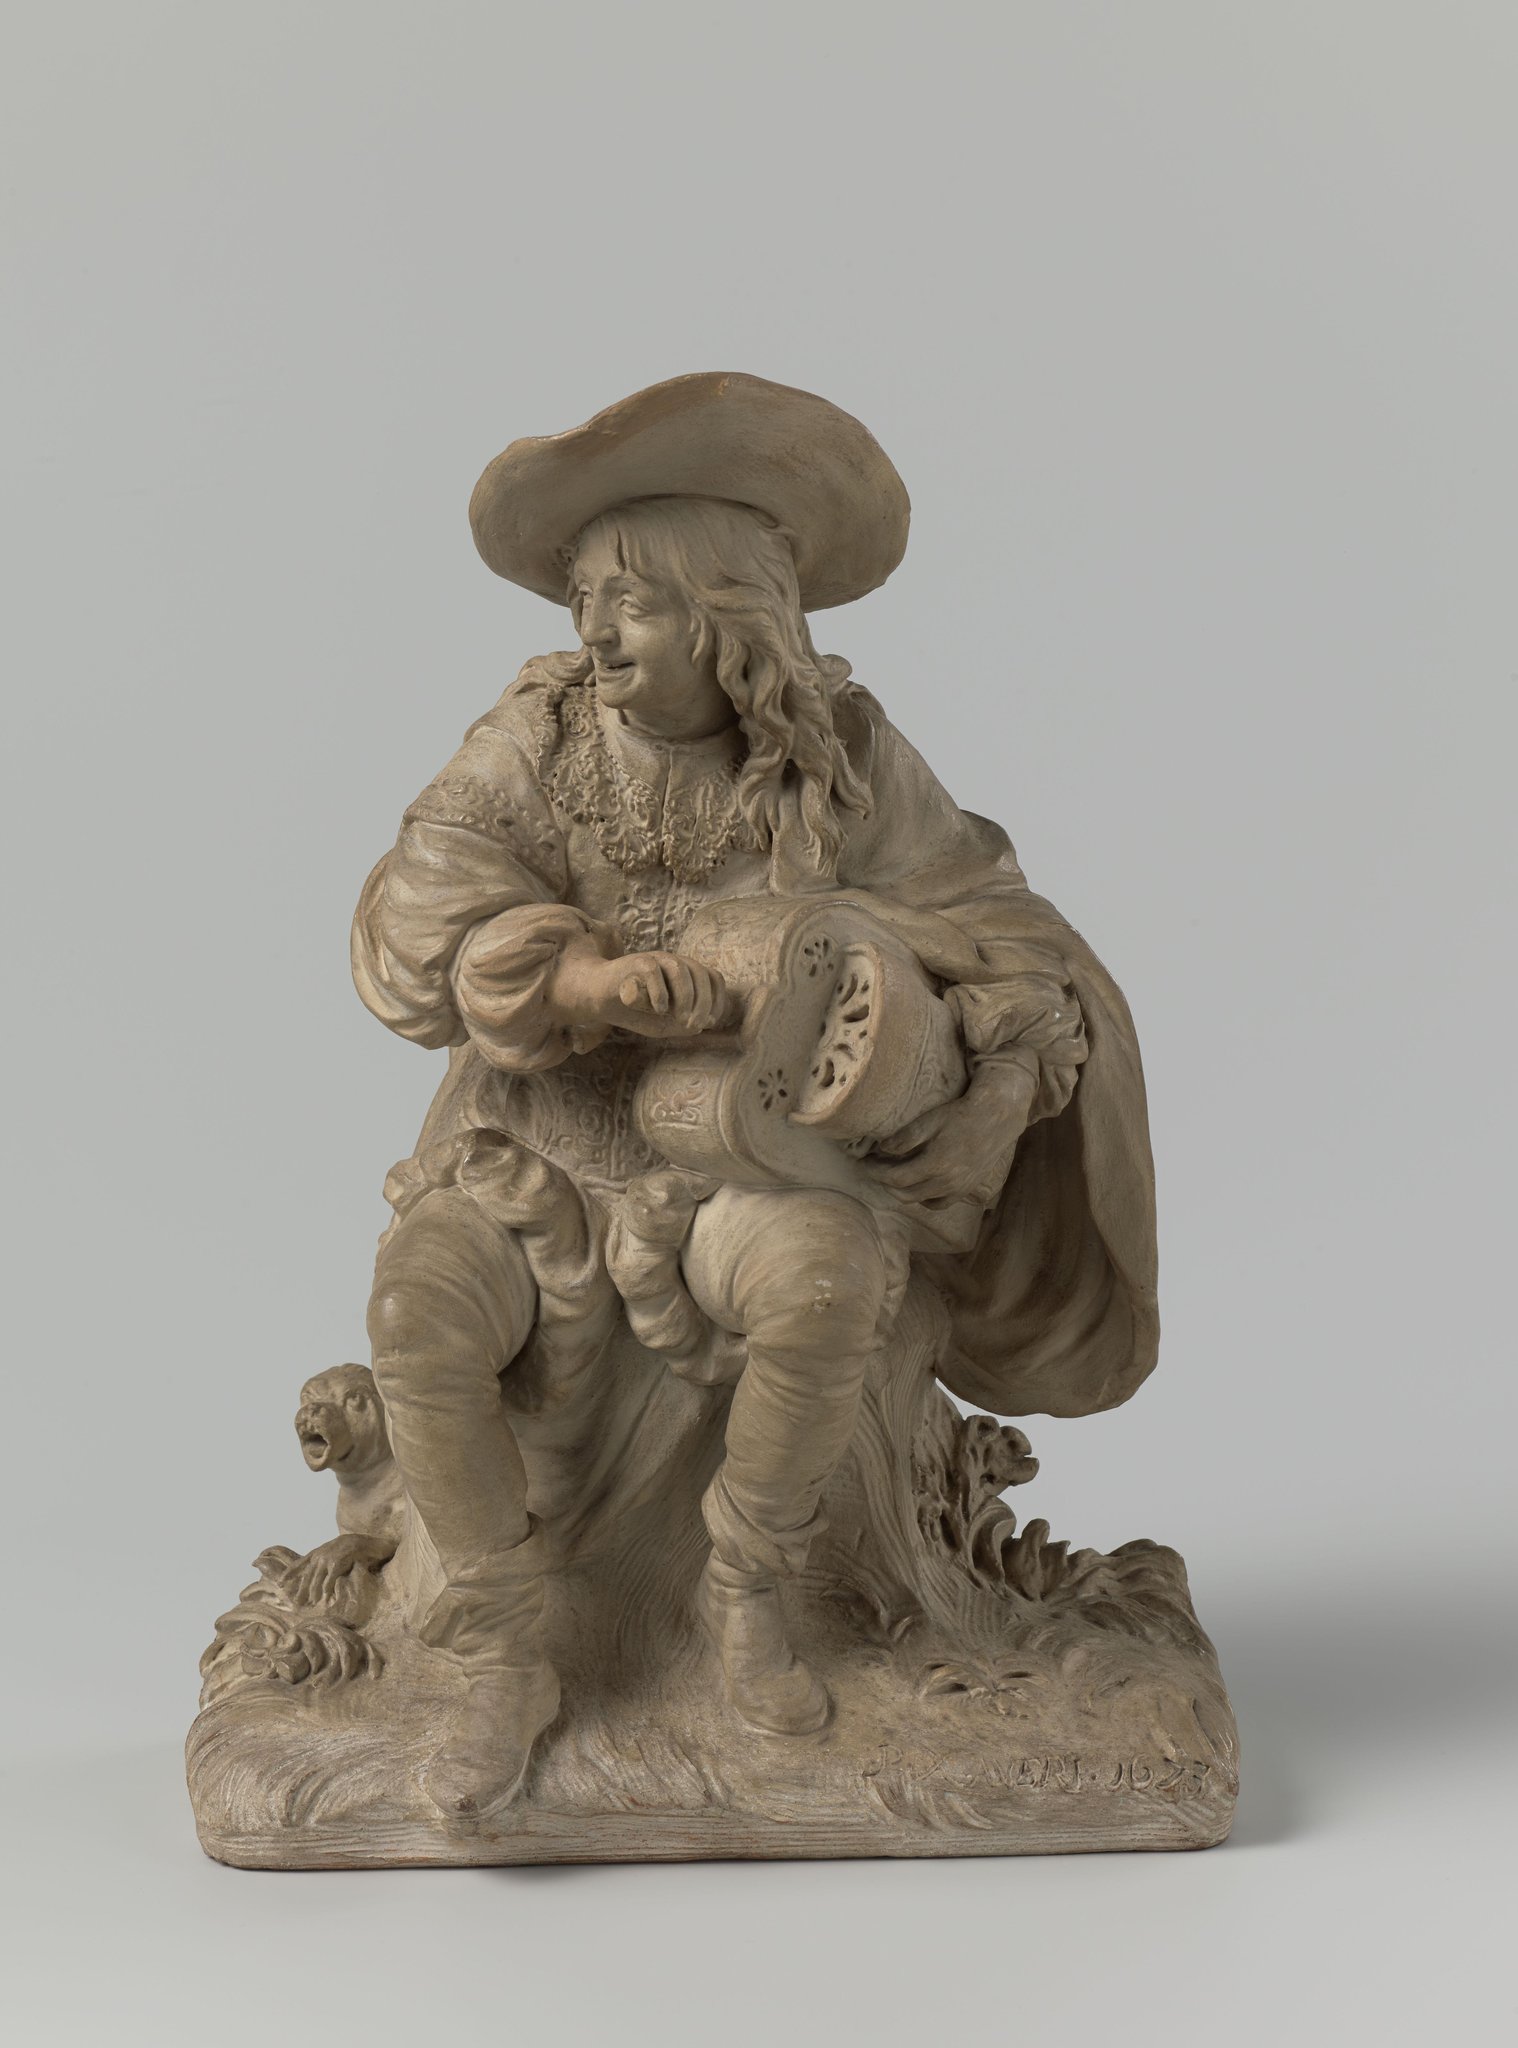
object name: figure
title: Hurdy-Gurdy Player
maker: pieter xaveri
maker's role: sculptor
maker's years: 1647-1673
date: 1673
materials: terracotta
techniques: modeling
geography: leiden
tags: hurdy-gurdy player - cc - out of doors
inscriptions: signature and date, front right on the plinth, incised in the wet clay: ‘P.XAVERI.1673’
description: Pieter Xavery (c. 1647 - 1674, 1673). Young man with a hurdy-gurdy. Terracotta. Acquired with the support of the Vereniging Rembrandt.